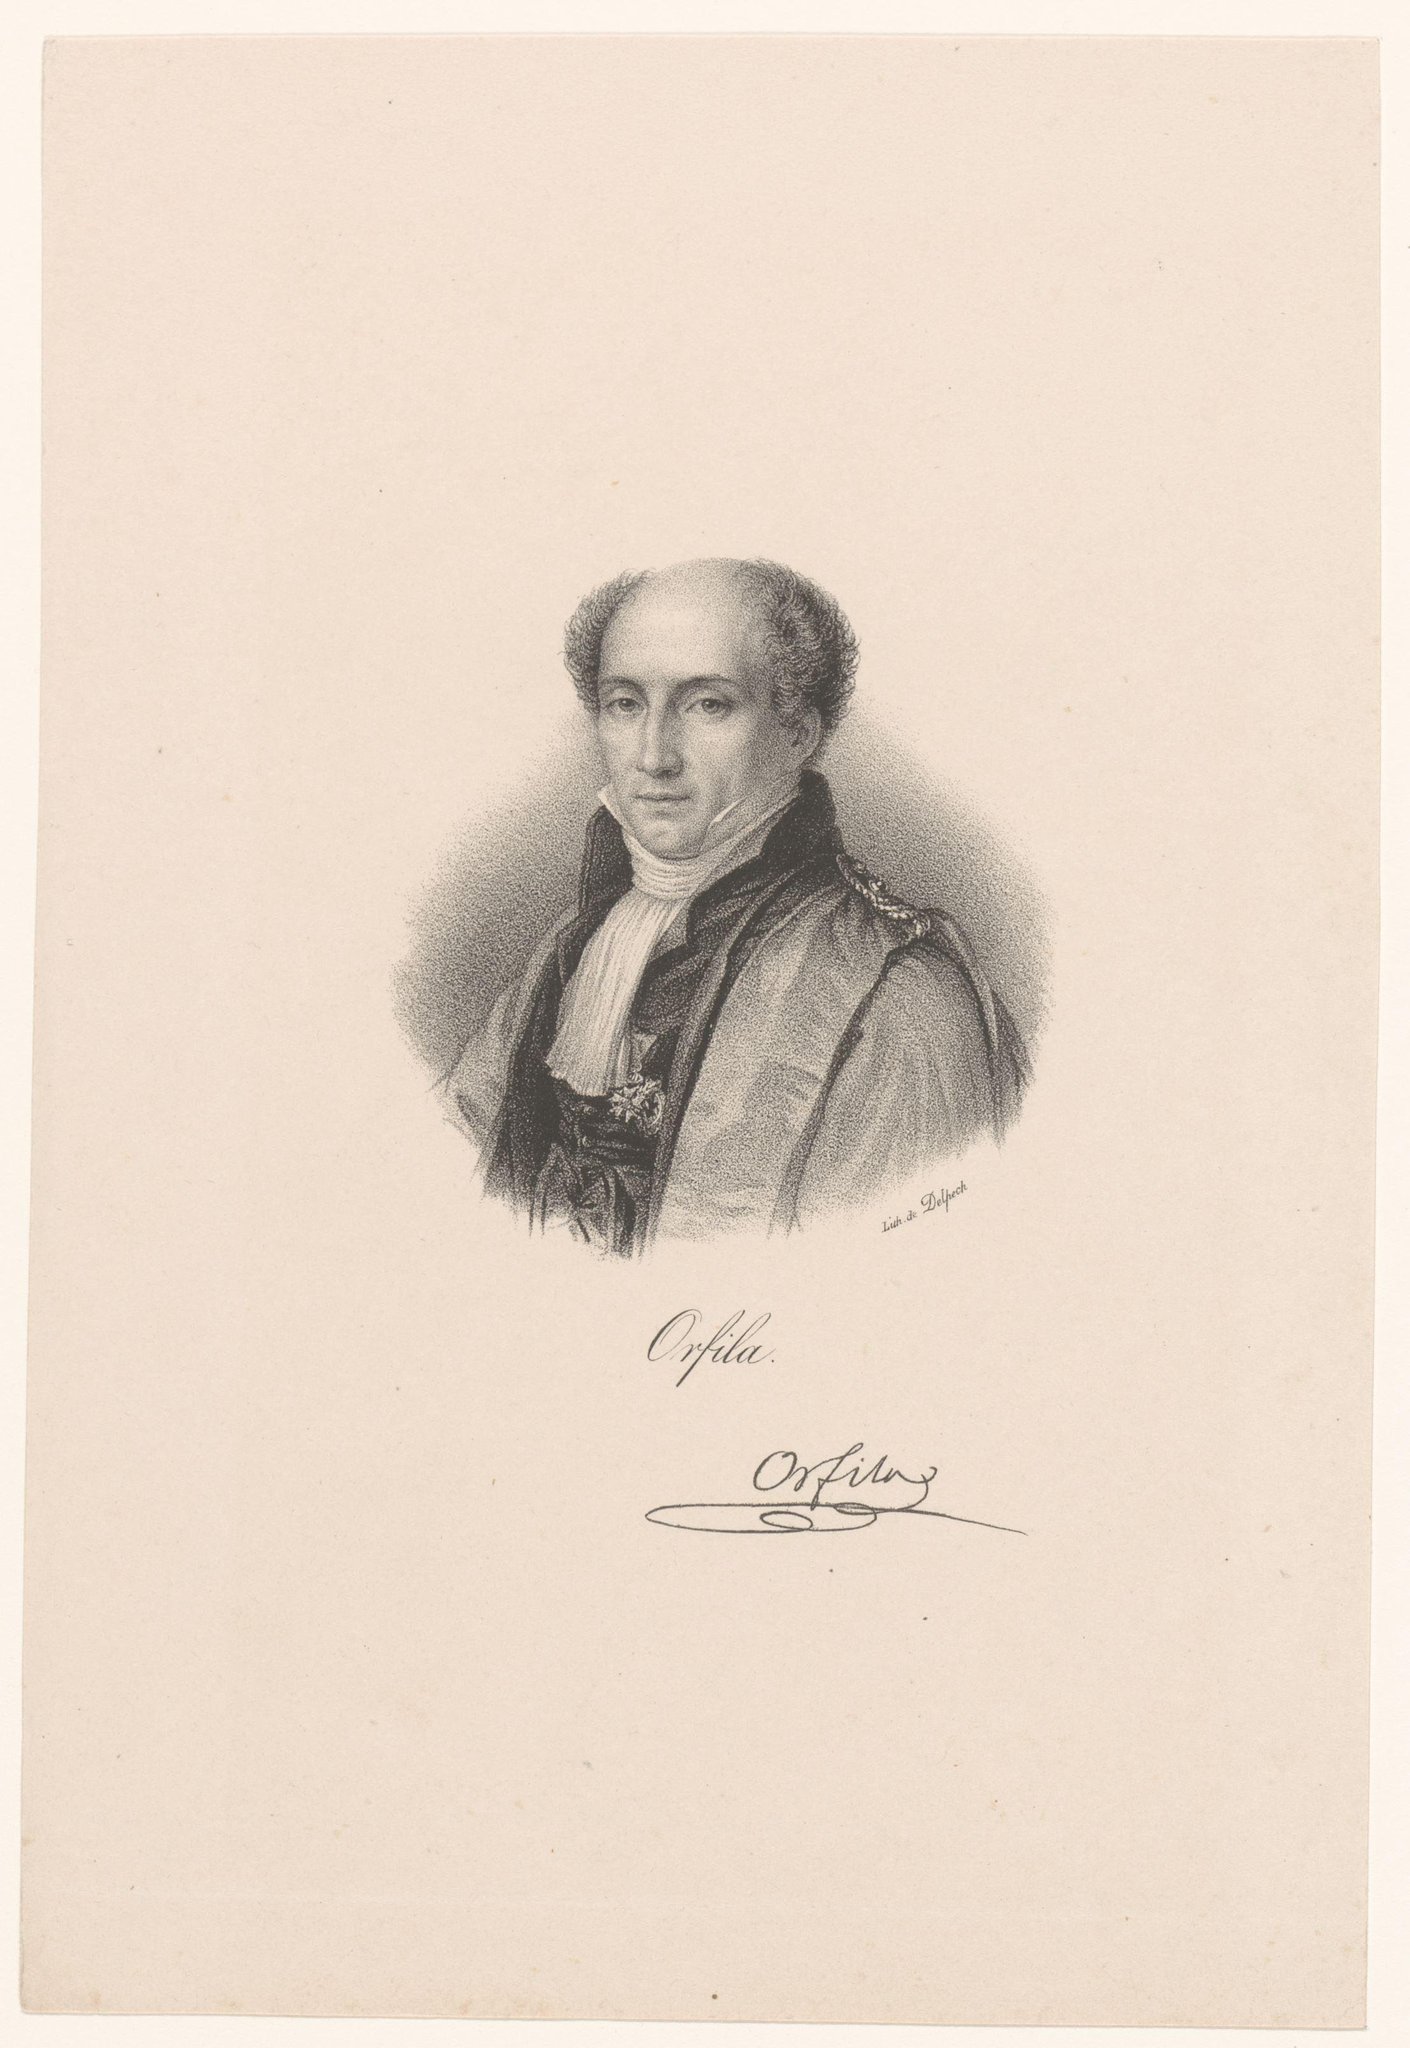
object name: print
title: Portret van Mathieu Orfila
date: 1835-1842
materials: paper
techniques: lithograph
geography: paris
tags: historical persons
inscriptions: collector's mark: Lugt 2228a